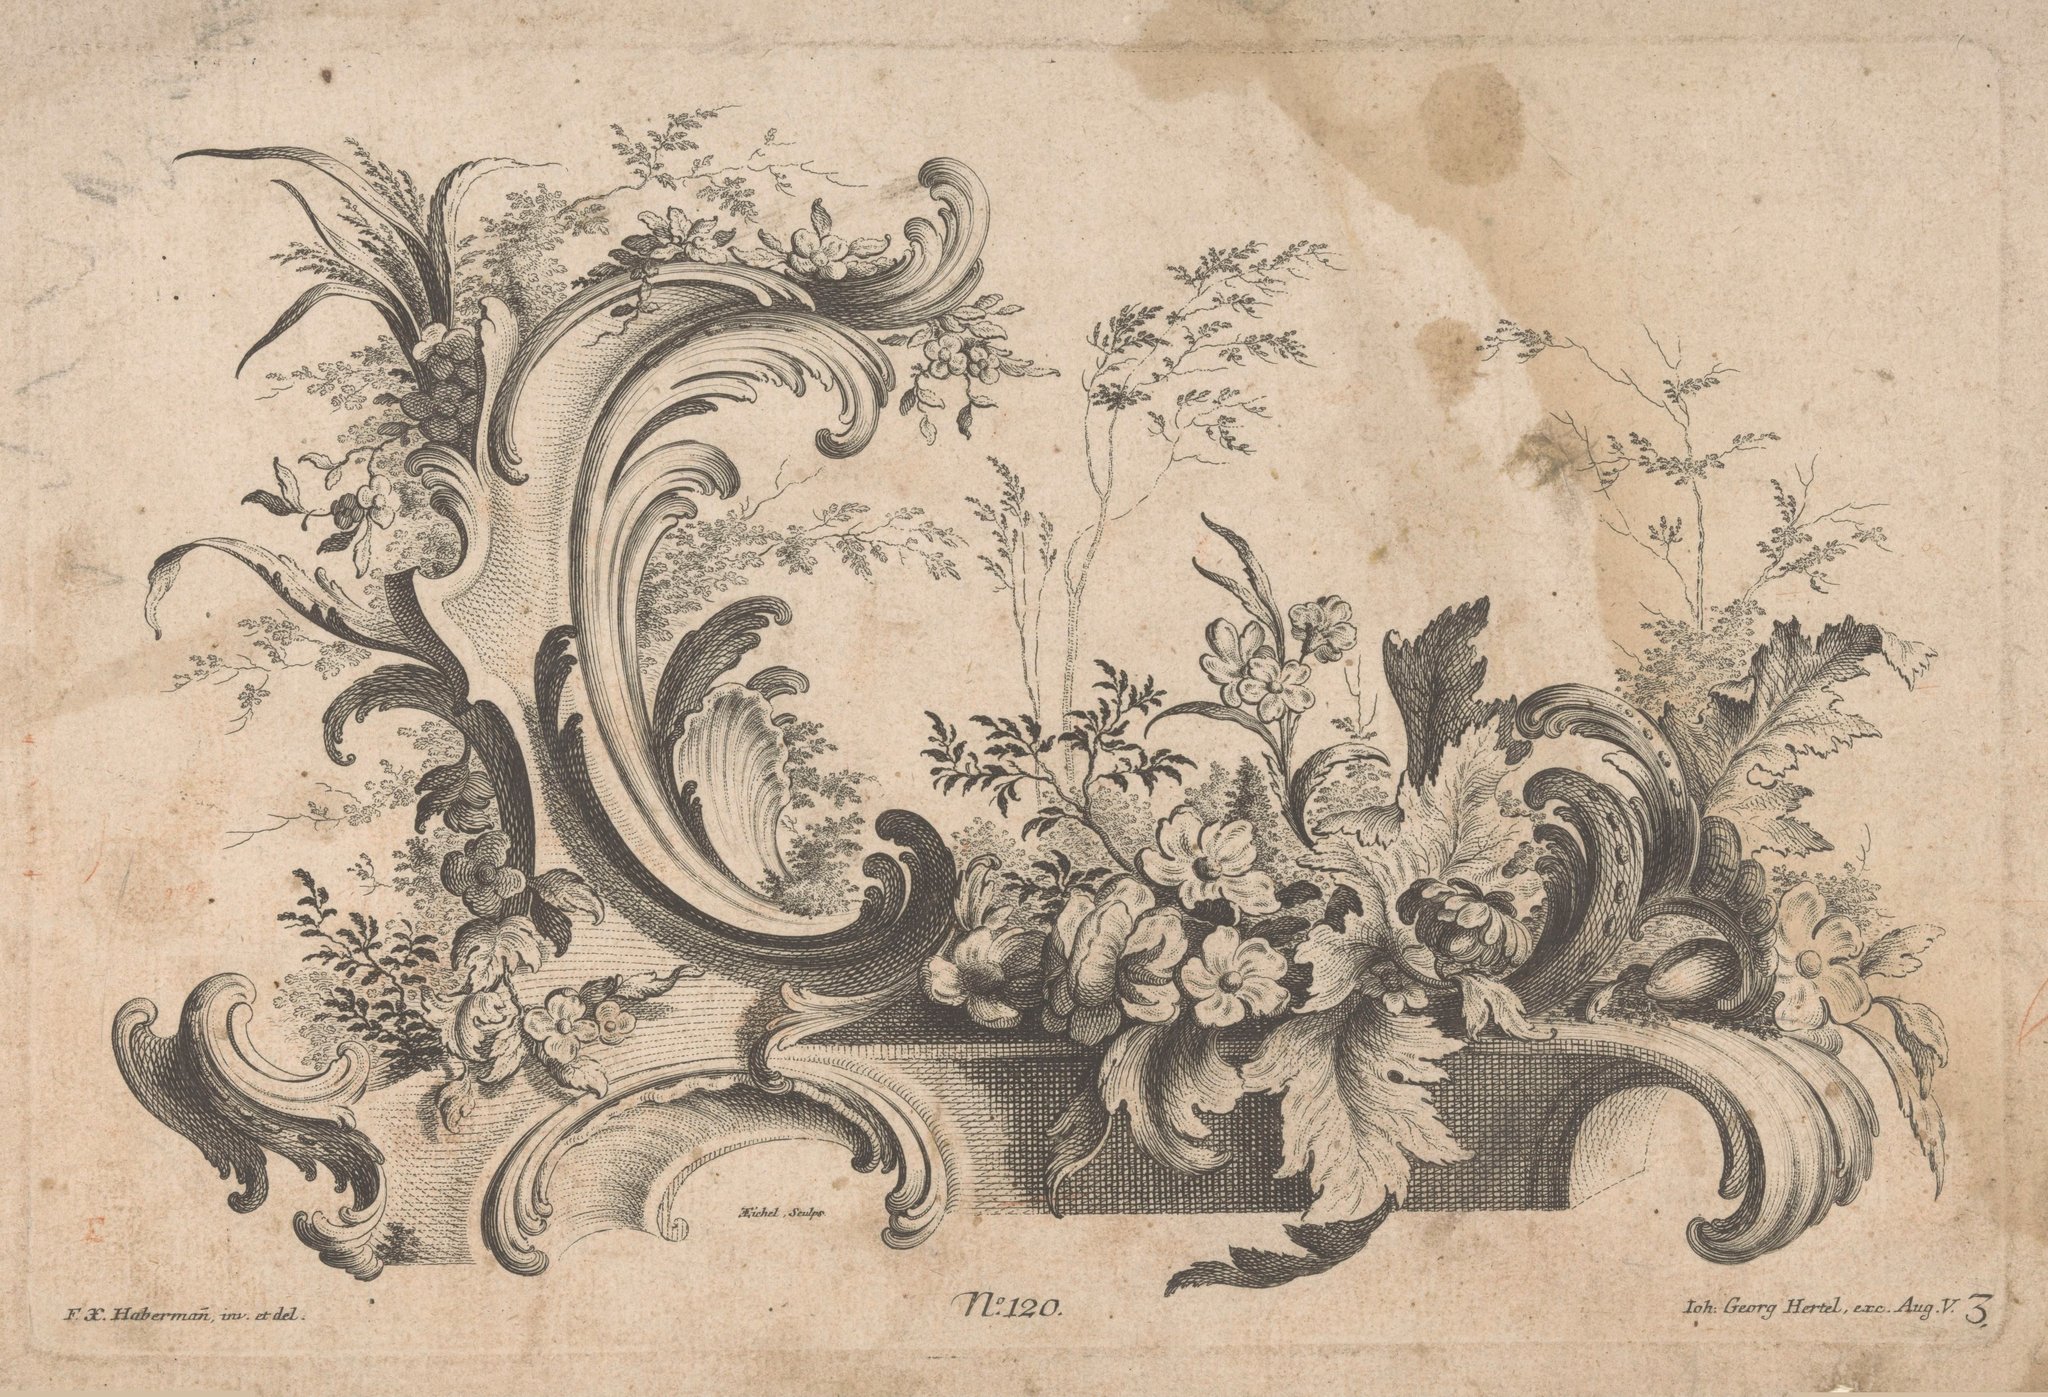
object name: print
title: Ontwerpen van rocailles met bloemen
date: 1731-1775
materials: paper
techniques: etching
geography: augsburg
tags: rocaille ornament, flowers ~ ornament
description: Rocaille ornament in landschap met bloemen. Uitgeversnummer 120.